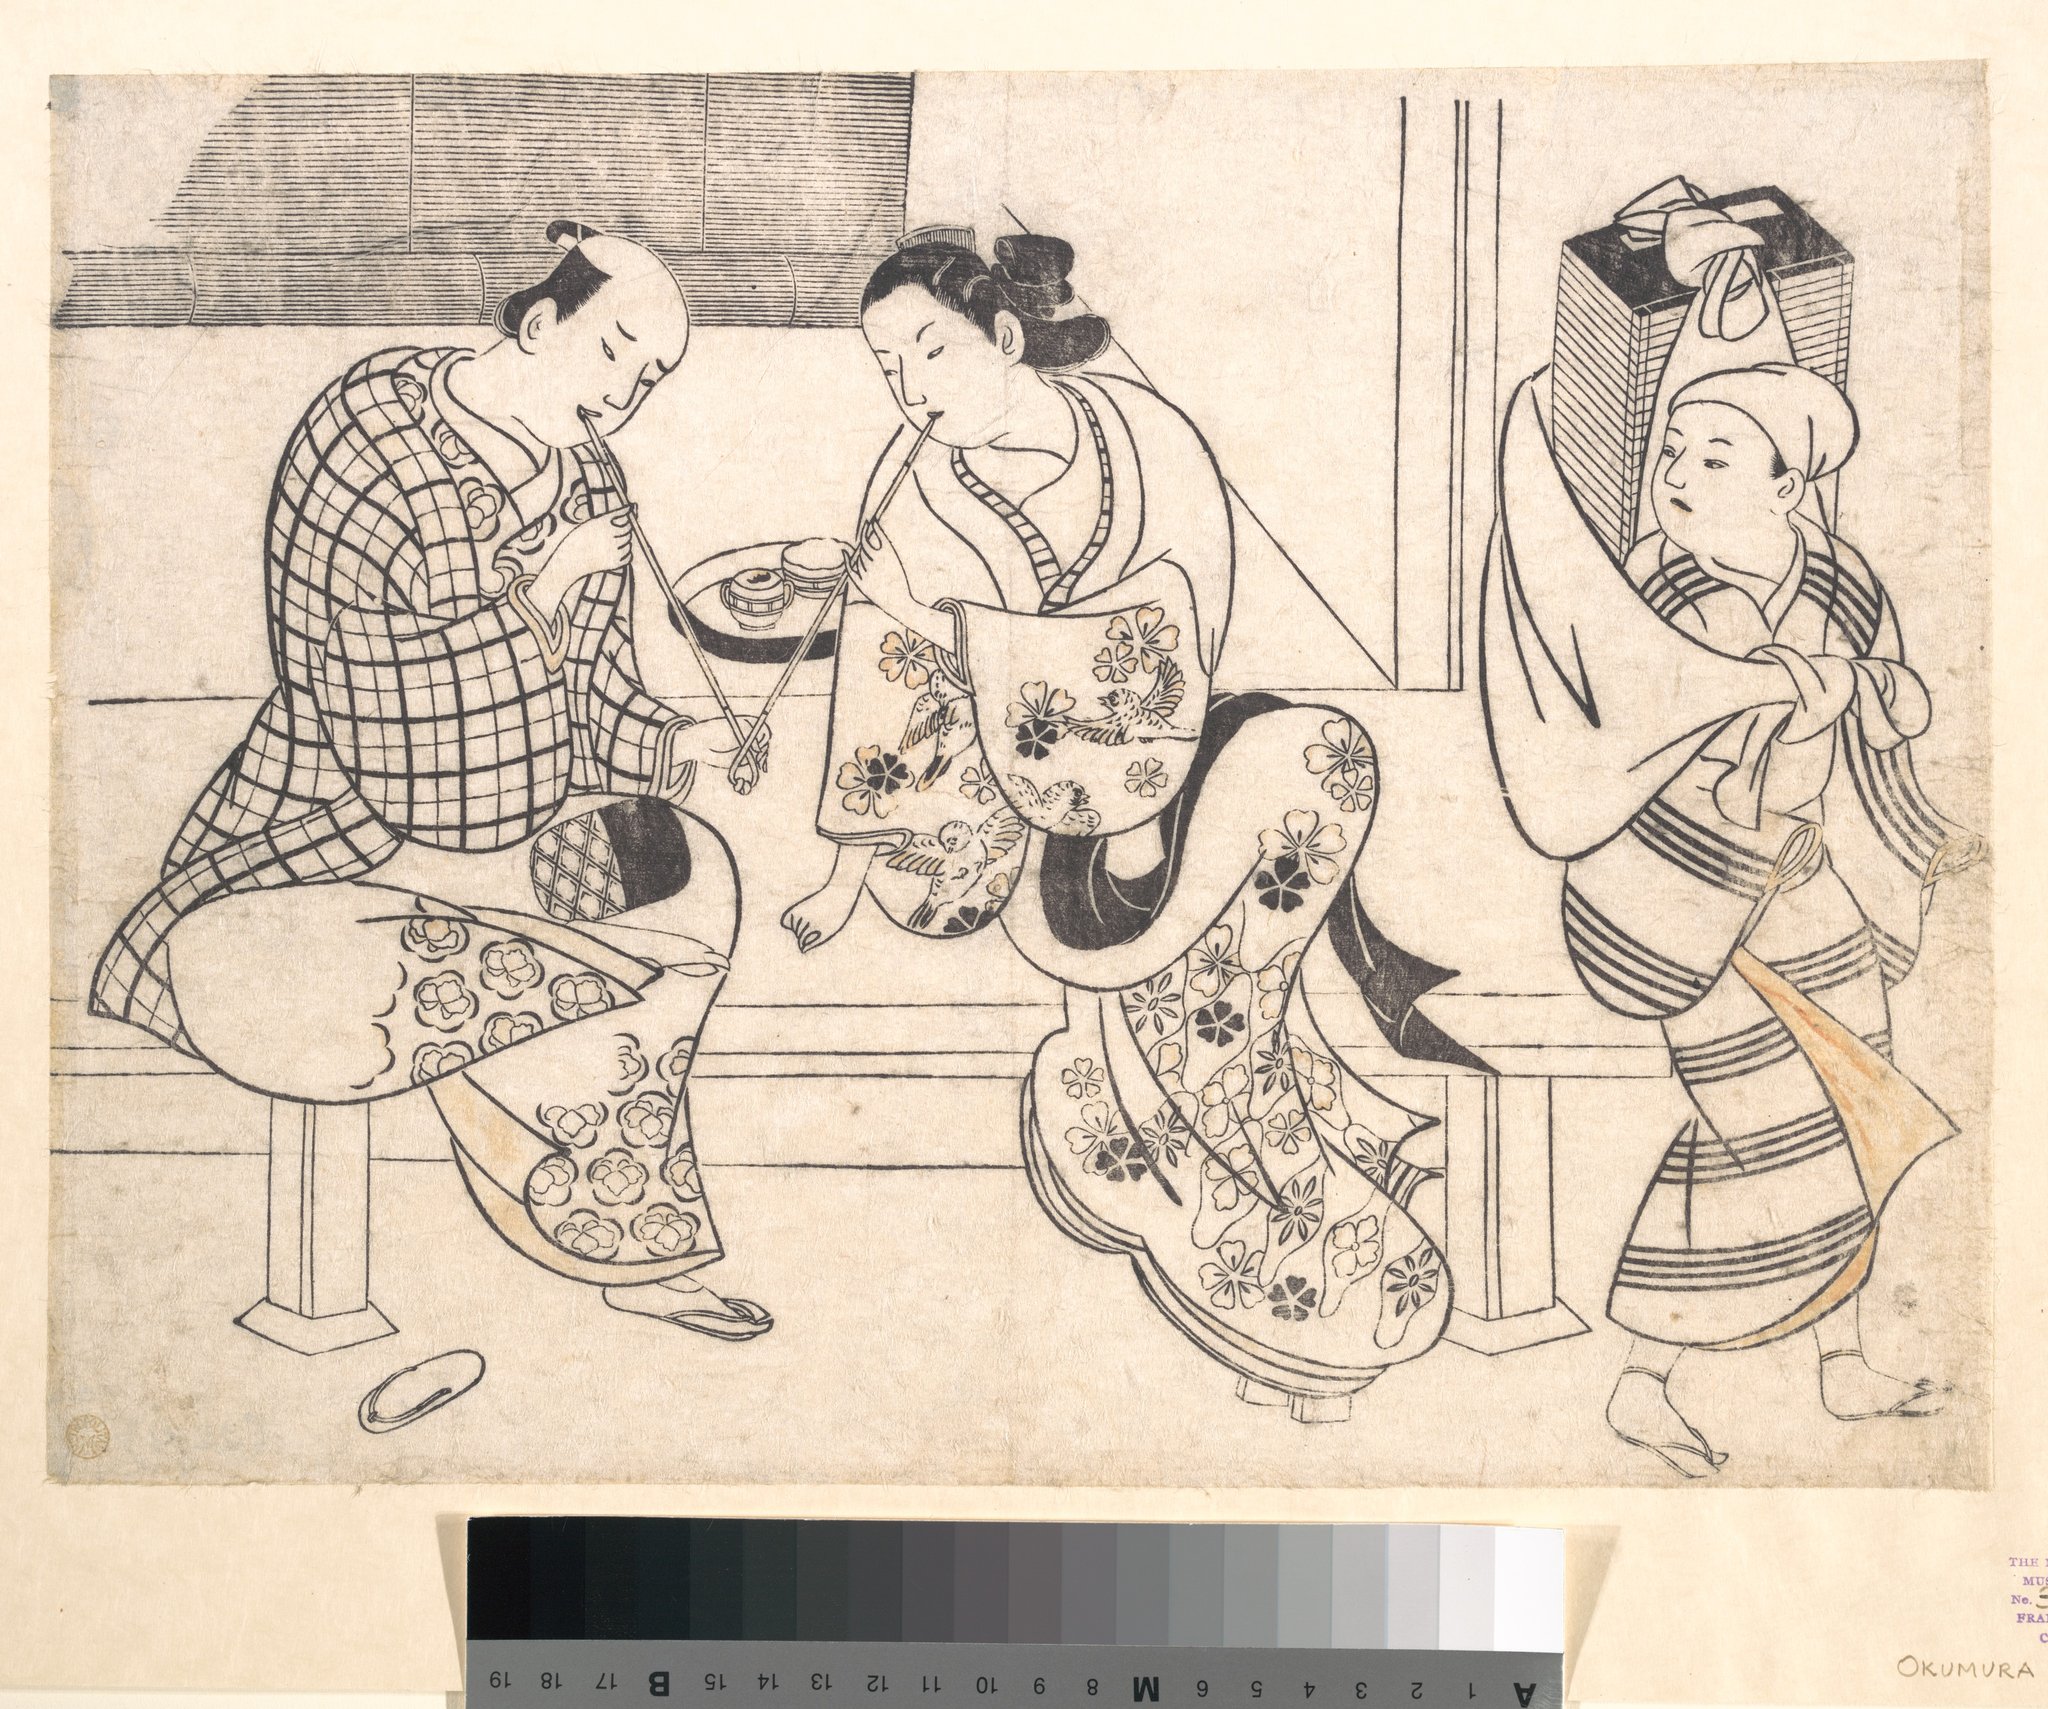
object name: print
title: Amorous Couple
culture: japanese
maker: okumura masanobu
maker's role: artist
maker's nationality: japanese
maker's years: 1686-1764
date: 1701-1733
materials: ink, paper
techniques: woodblock print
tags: boys,couples,men,women,smoking